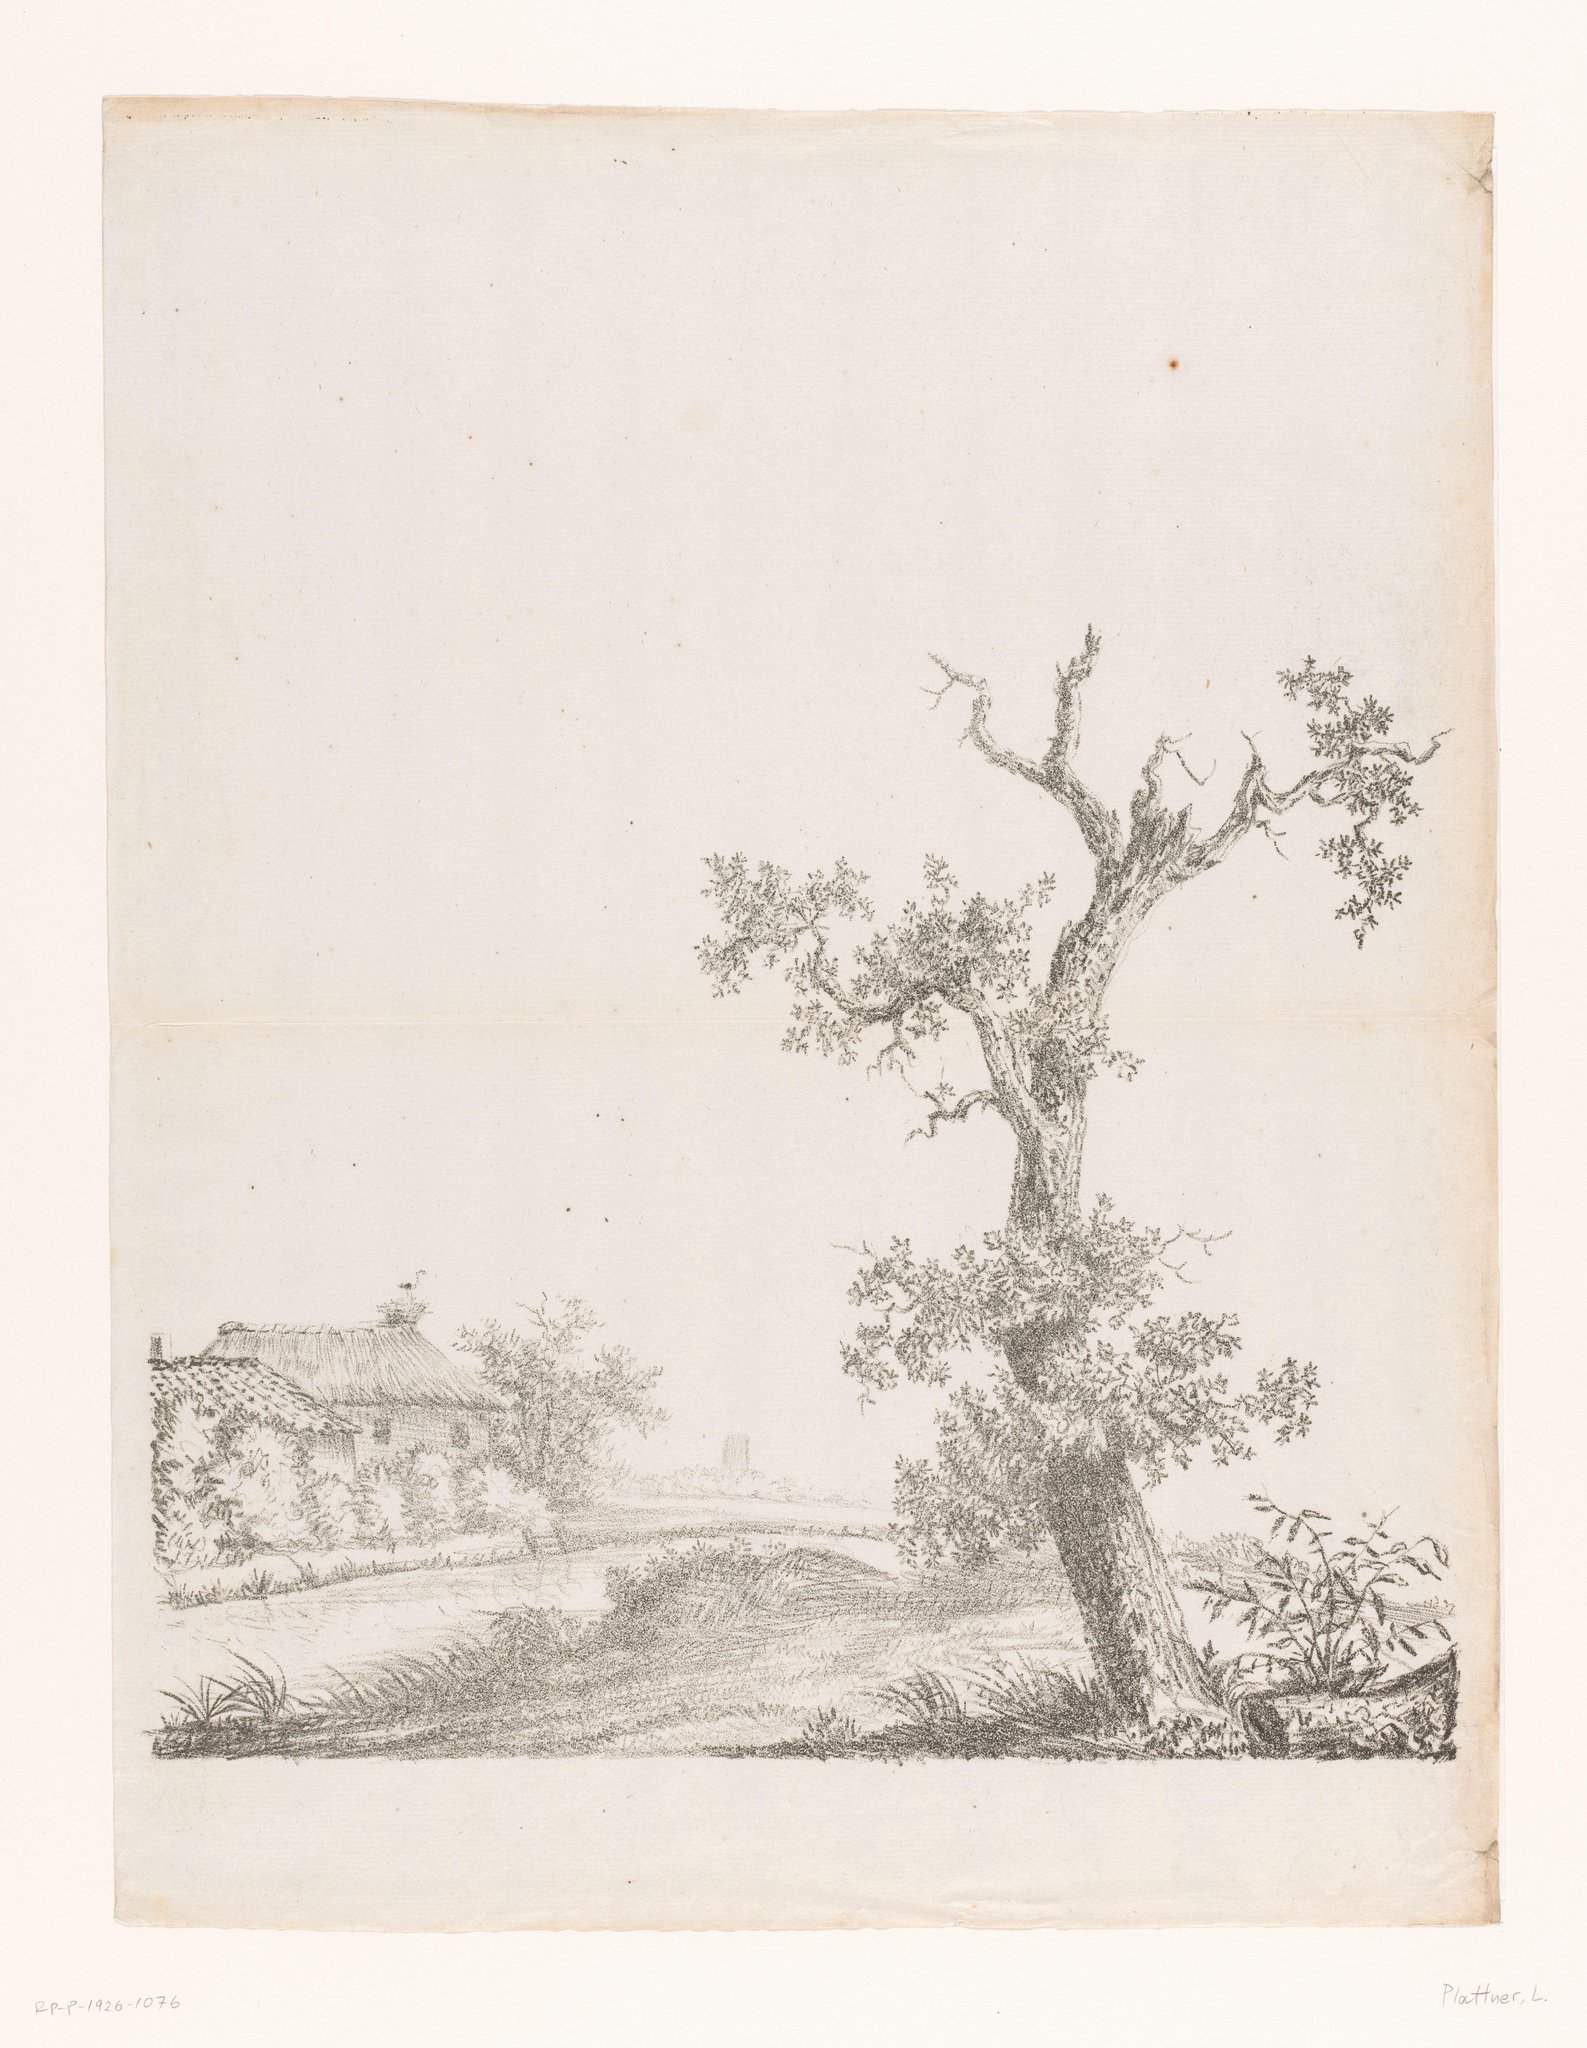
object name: print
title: Boom in landschap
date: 1809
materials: paper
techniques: lithograph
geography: rotterdam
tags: trees, rotterdam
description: Een boom in een landschap met links een huis langs het water en in de achtergrond een stompe kerktoren (mogelijk van Rotterdam).